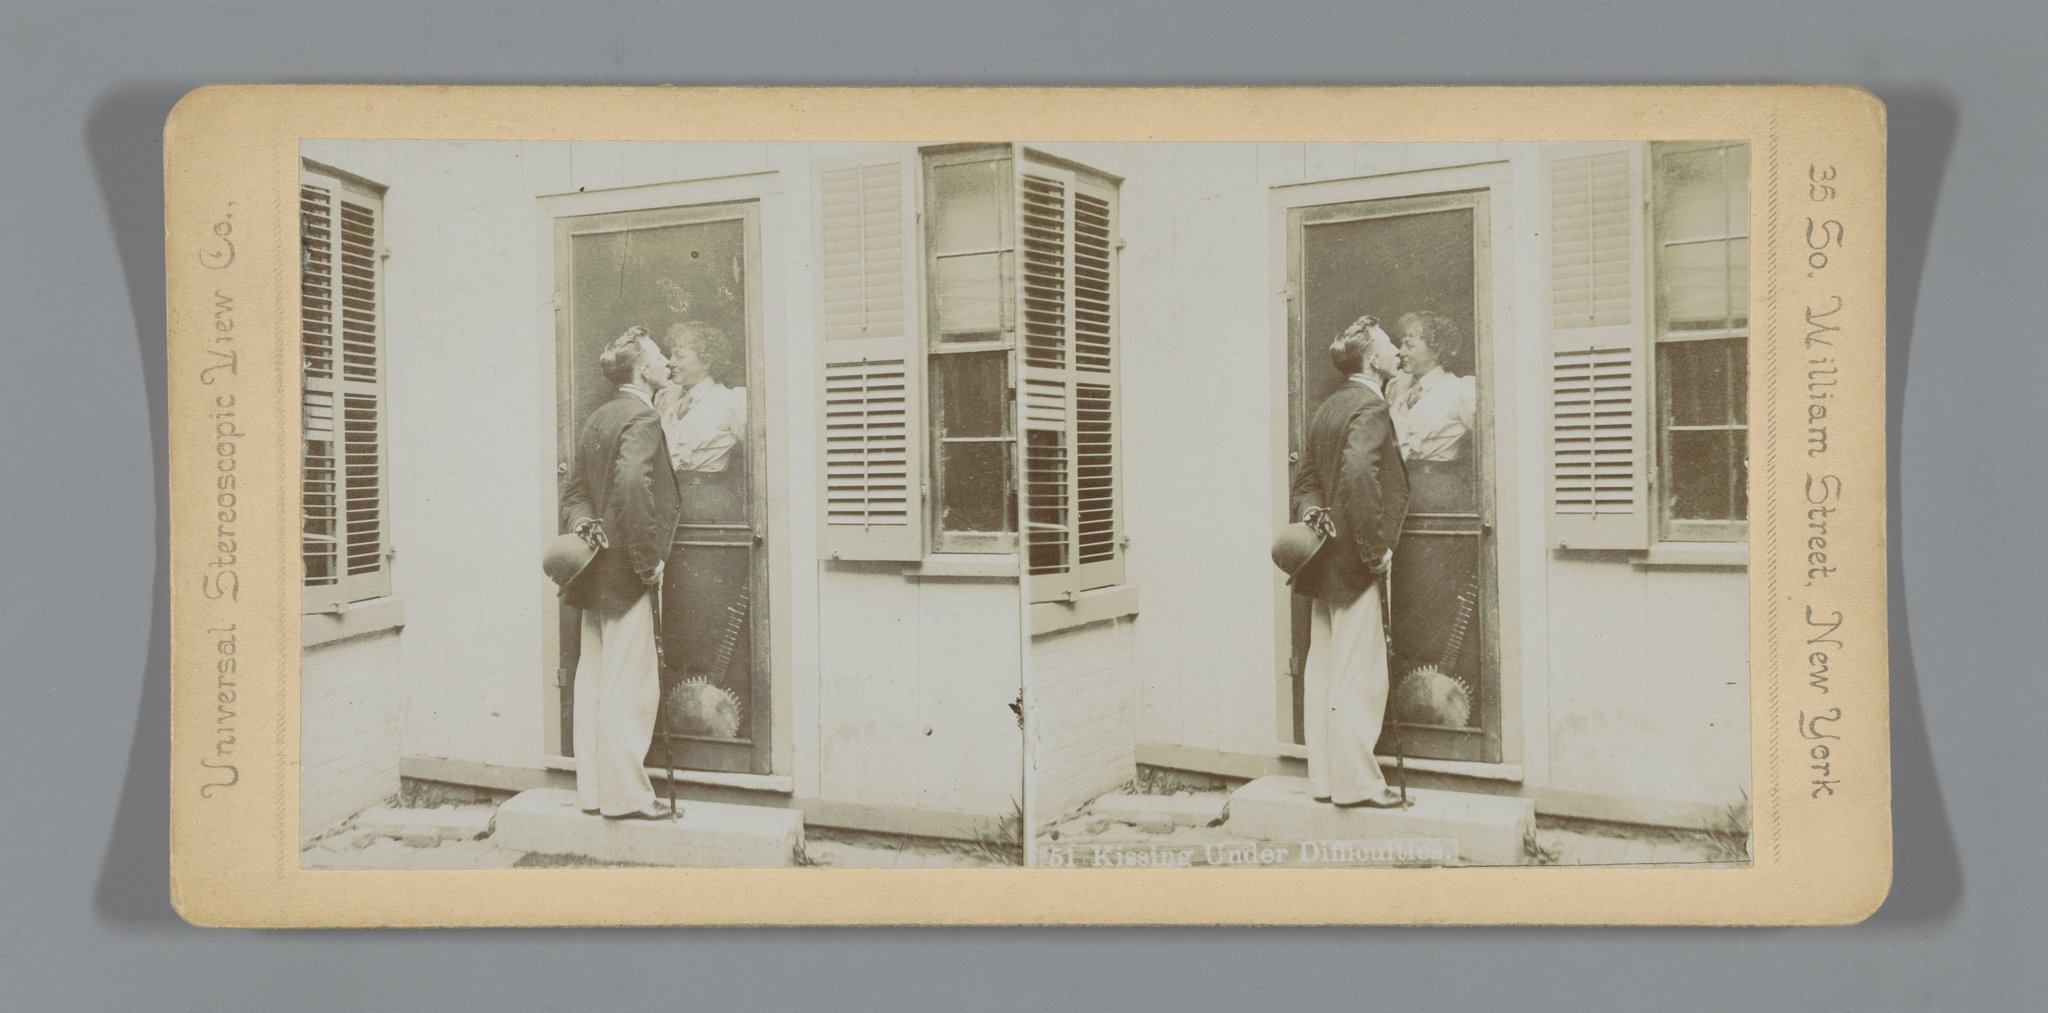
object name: stereograph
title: Kussend paar in deuropening met een hor tussen beiden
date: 1890-1910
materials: cardboard, photographic support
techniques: gelatin silver print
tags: door, couple of lovers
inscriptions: number: ‘41’, : ‘35 So. William Street, New York’, number: ‘51’